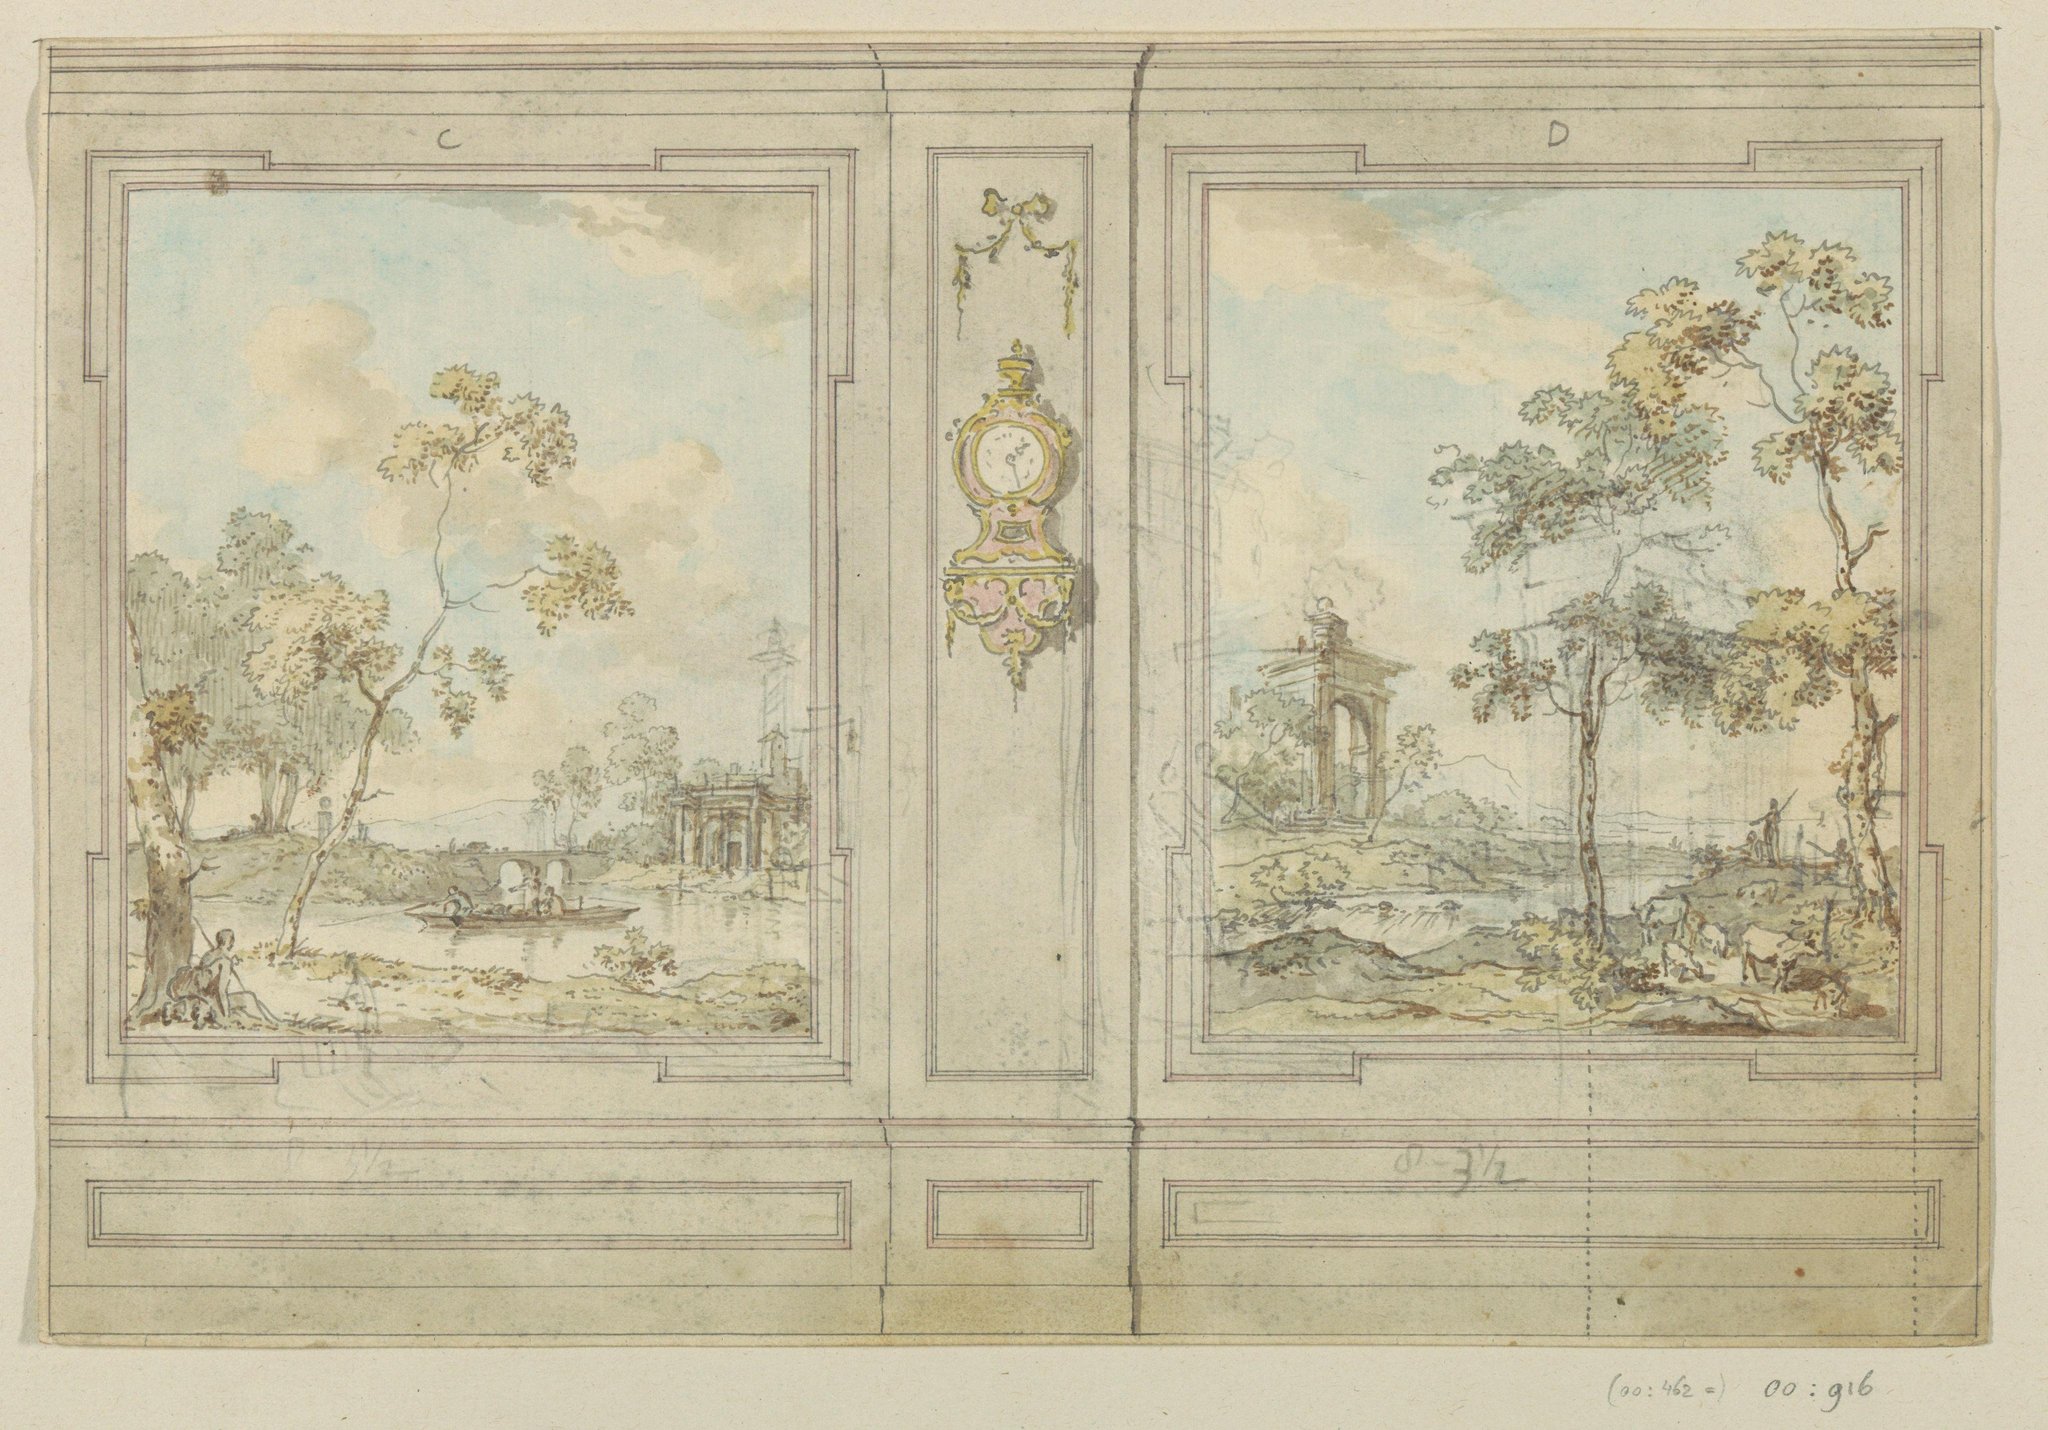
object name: album leaf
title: Ontwerptekening voor een kamerwand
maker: jurriaan andriessen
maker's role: draughtsman, painter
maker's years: 1742-1819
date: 1760-1819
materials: paint, paper, pencil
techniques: brush, pen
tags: landscapes in the temperate zone, interior ~ architectural design or model, clock, wall-covering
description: Met aan beide kanten een waterlandschap met gebouwen en in het midden een klok. Tekening maakt deel uit van een album.